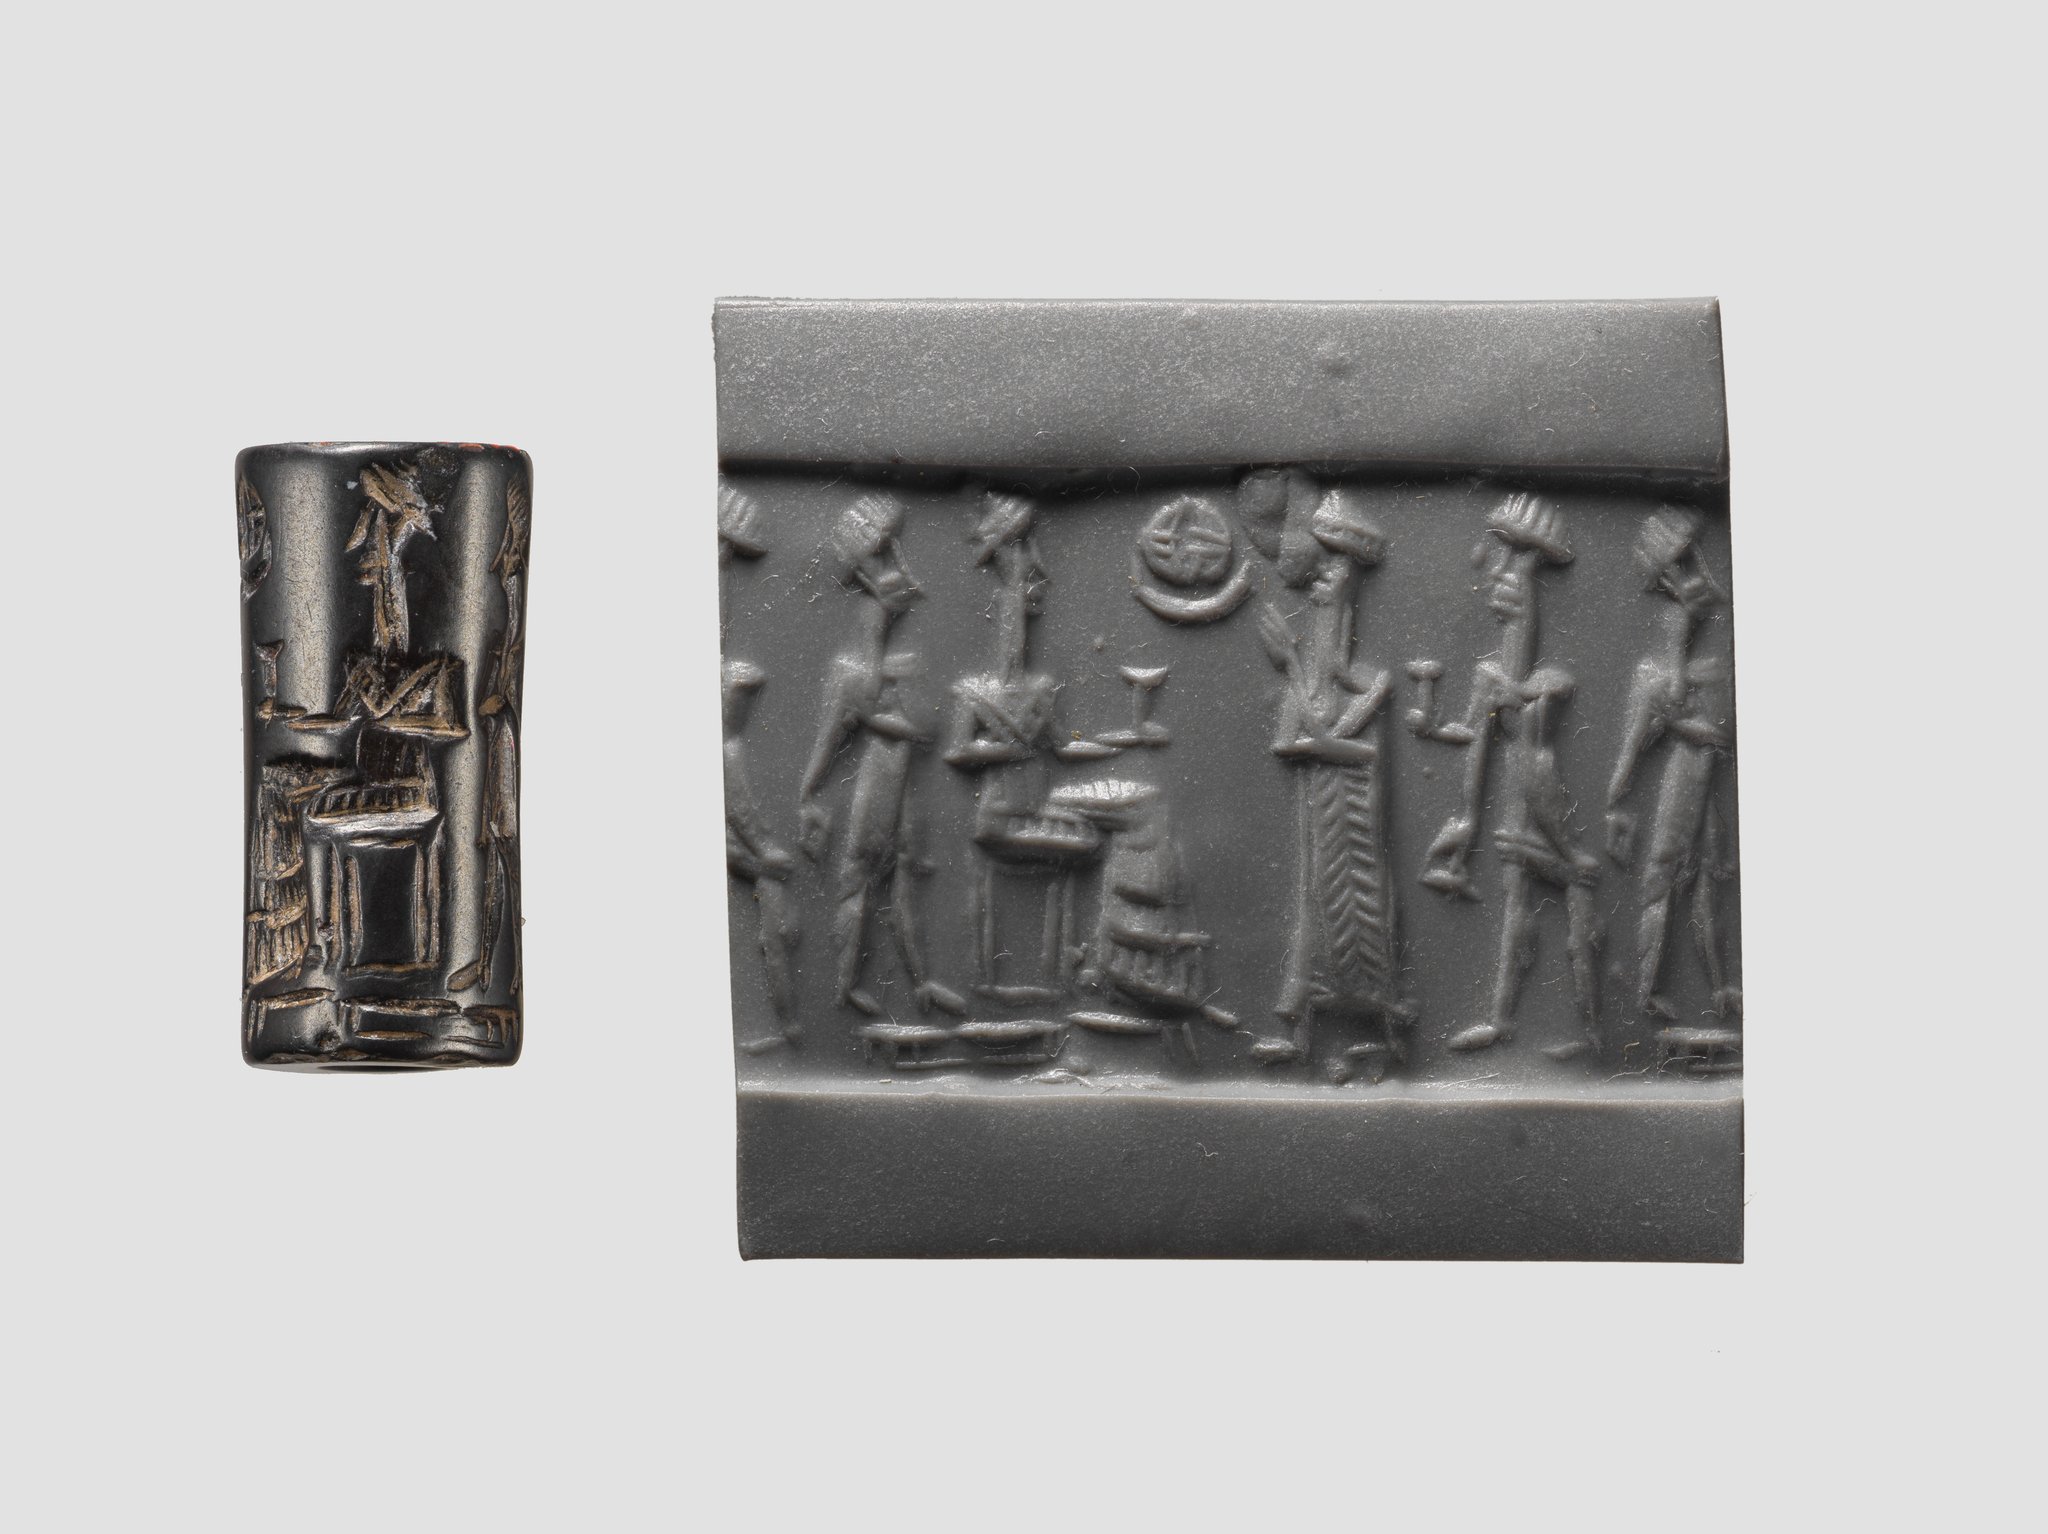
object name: cylinder seal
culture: assyrian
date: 2000-1668 BCE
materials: mineral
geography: anatolia or mesopotamia